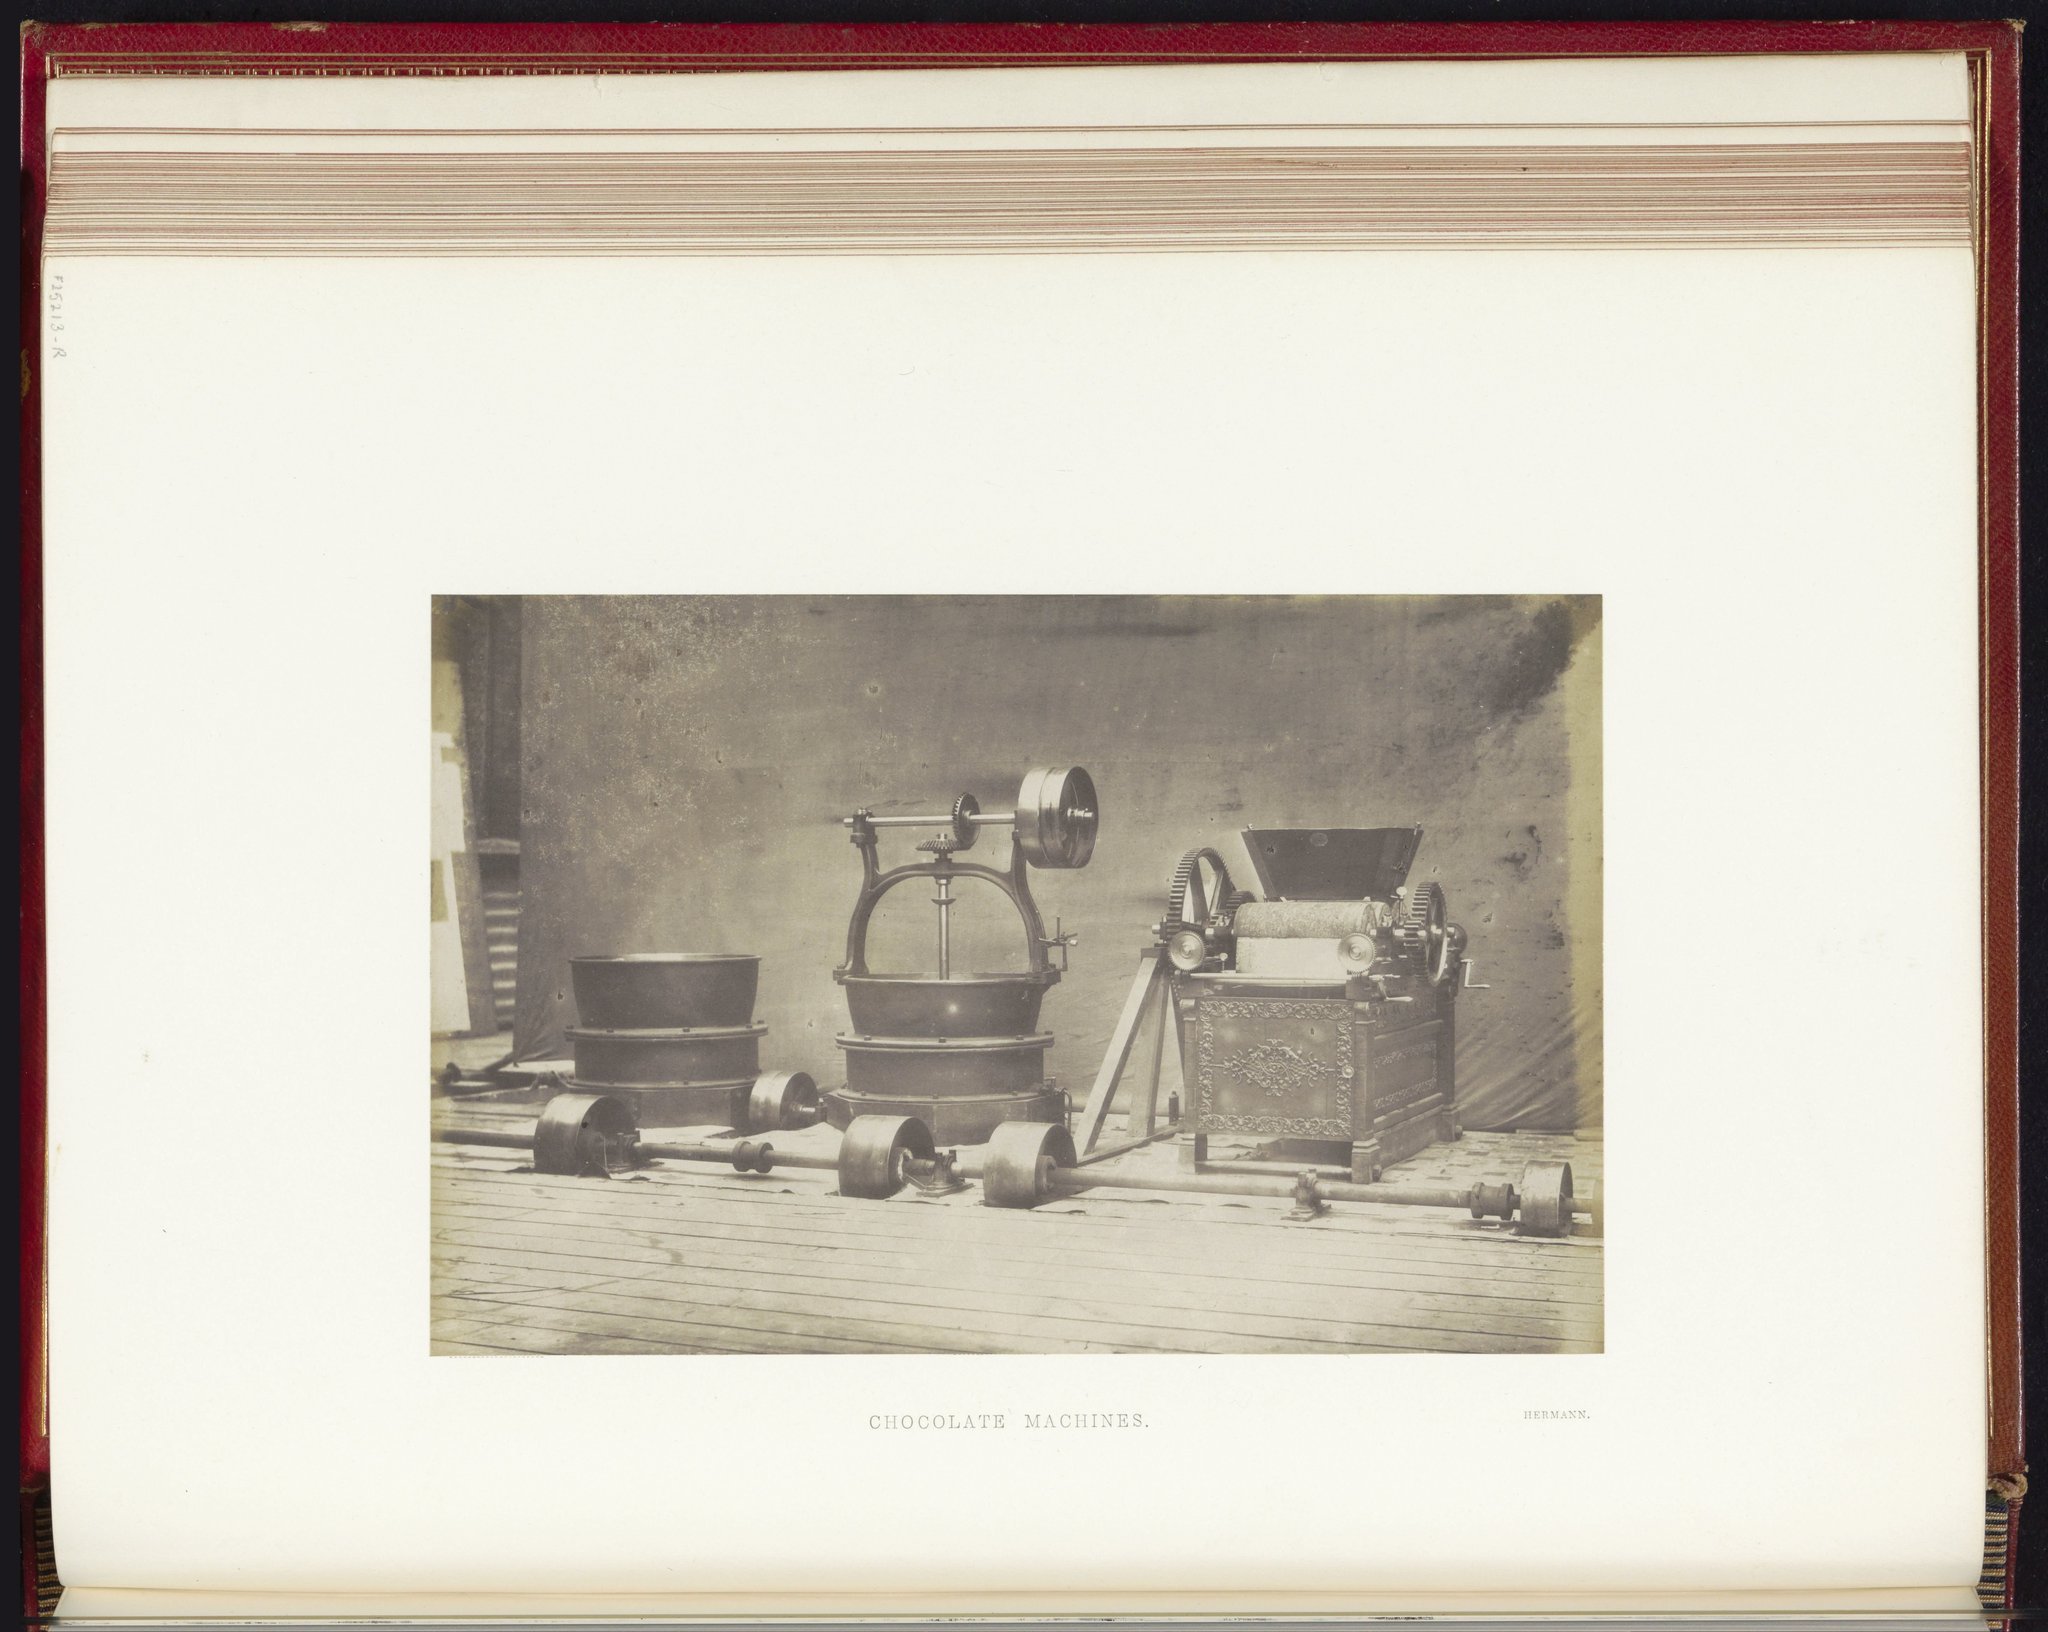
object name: page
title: Chocolate Machines. Hermann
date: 1851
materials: photographic support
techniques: salted paper print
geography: london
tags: machines; parts of machines; tools and appliances, london